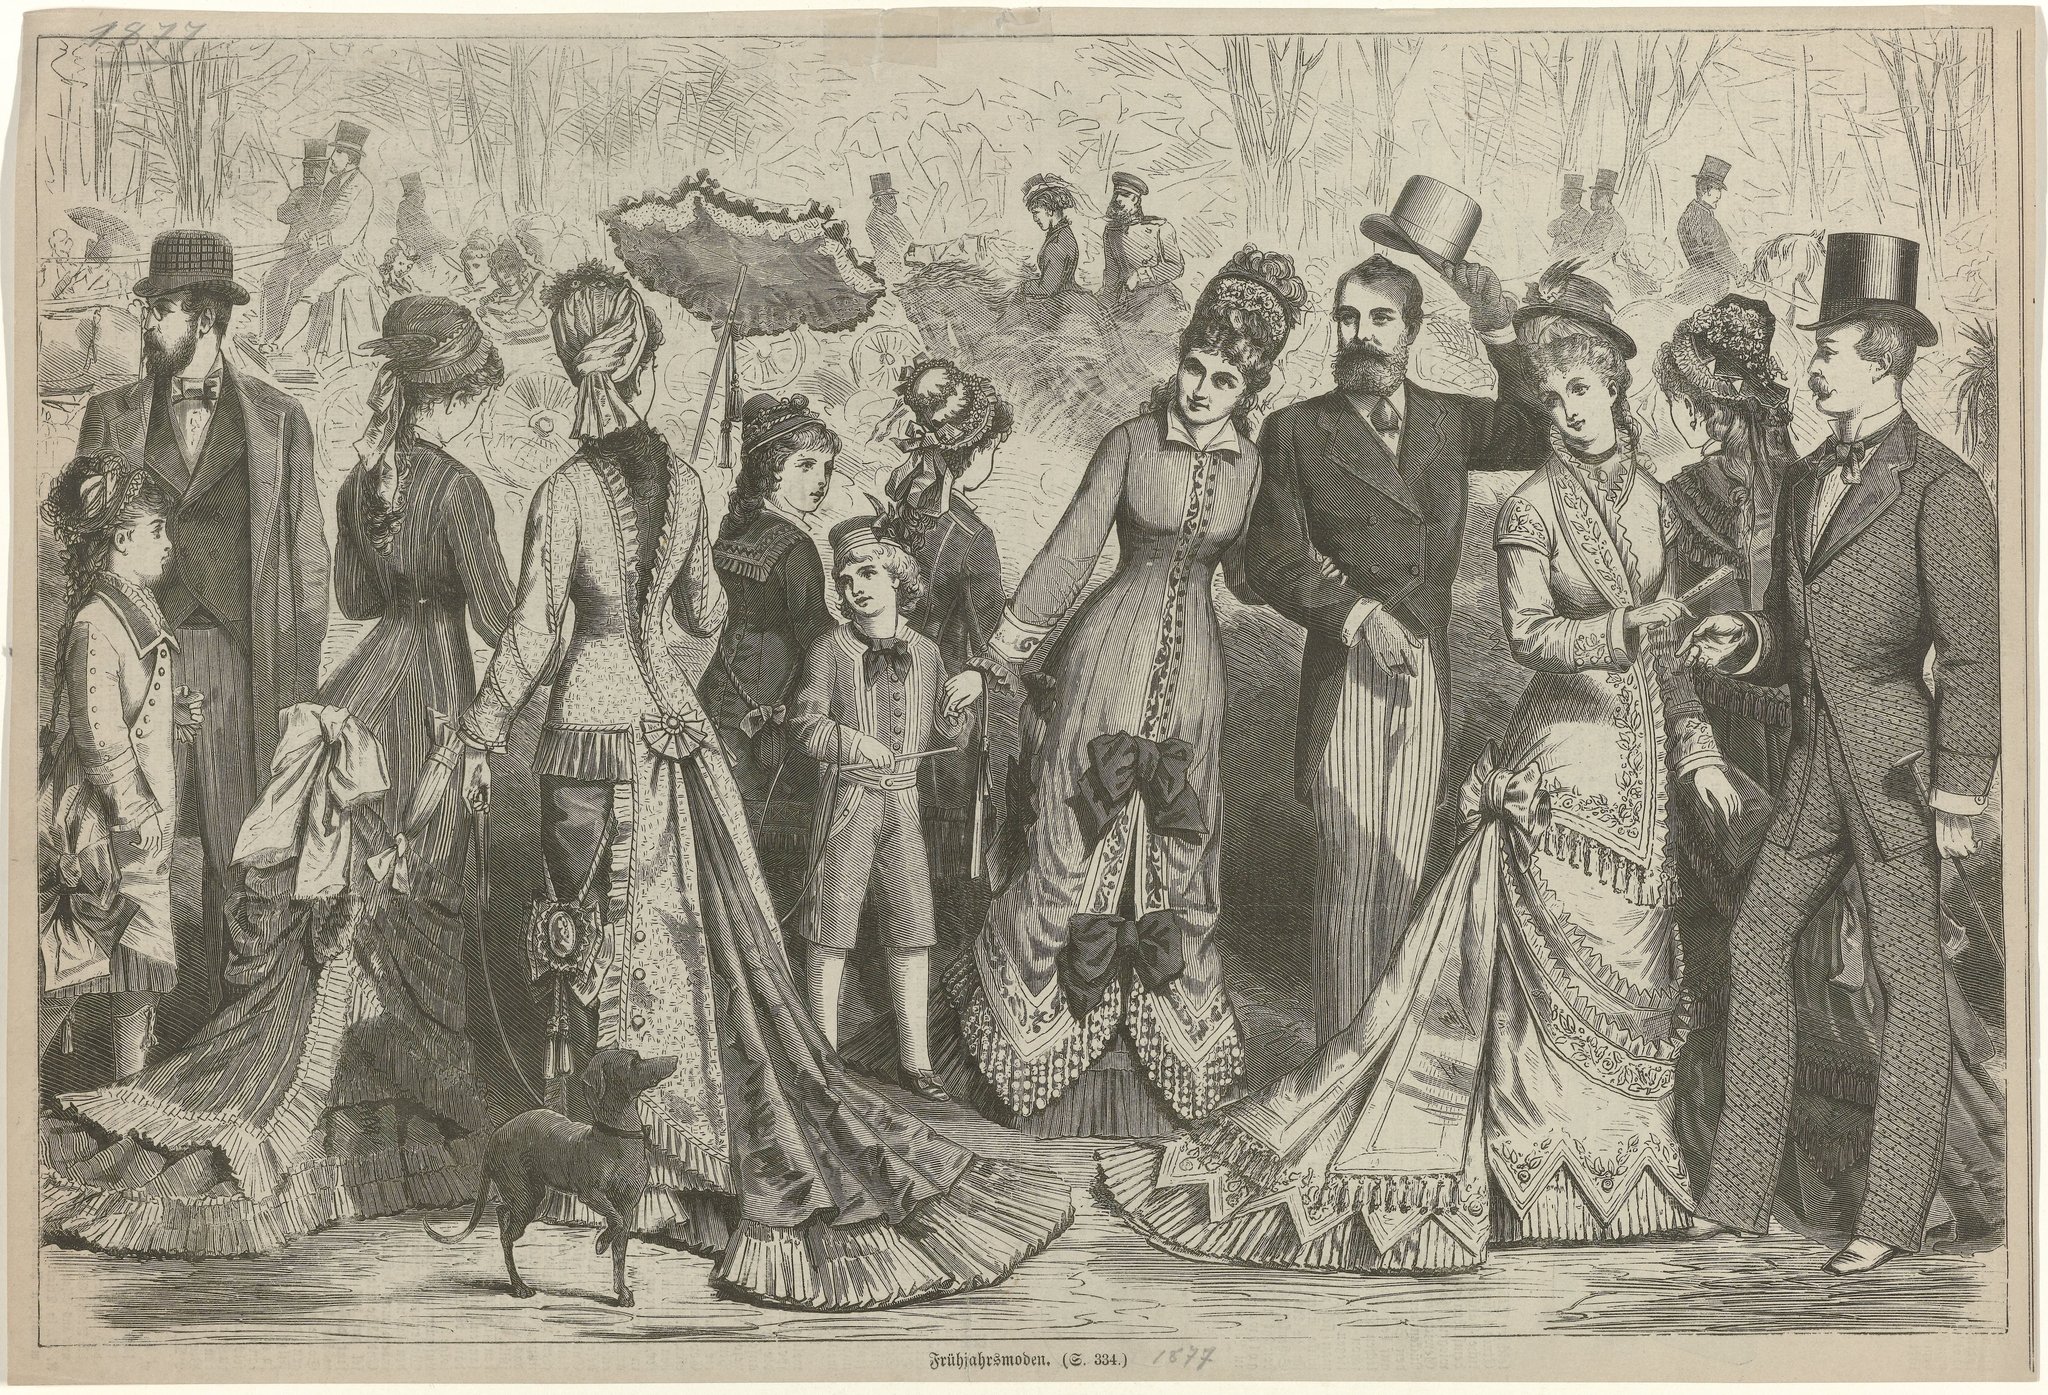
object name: fashion print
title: Frühjahrsmoden, 1877, Nr. 334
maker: Anonymous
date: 1877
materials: paper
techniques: engraving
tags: clothes, costume (+ girls' clothes), clothes, costume (+ boys' clothes), head-gear (+ women's clothes), fashion plates, clothes, costume (+ women's clothes), dress, gown (+ women's clothes), clothes, costume (+ men's clothes)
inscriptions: title: ‘Frühjahrsmoden. (C. 334.)’